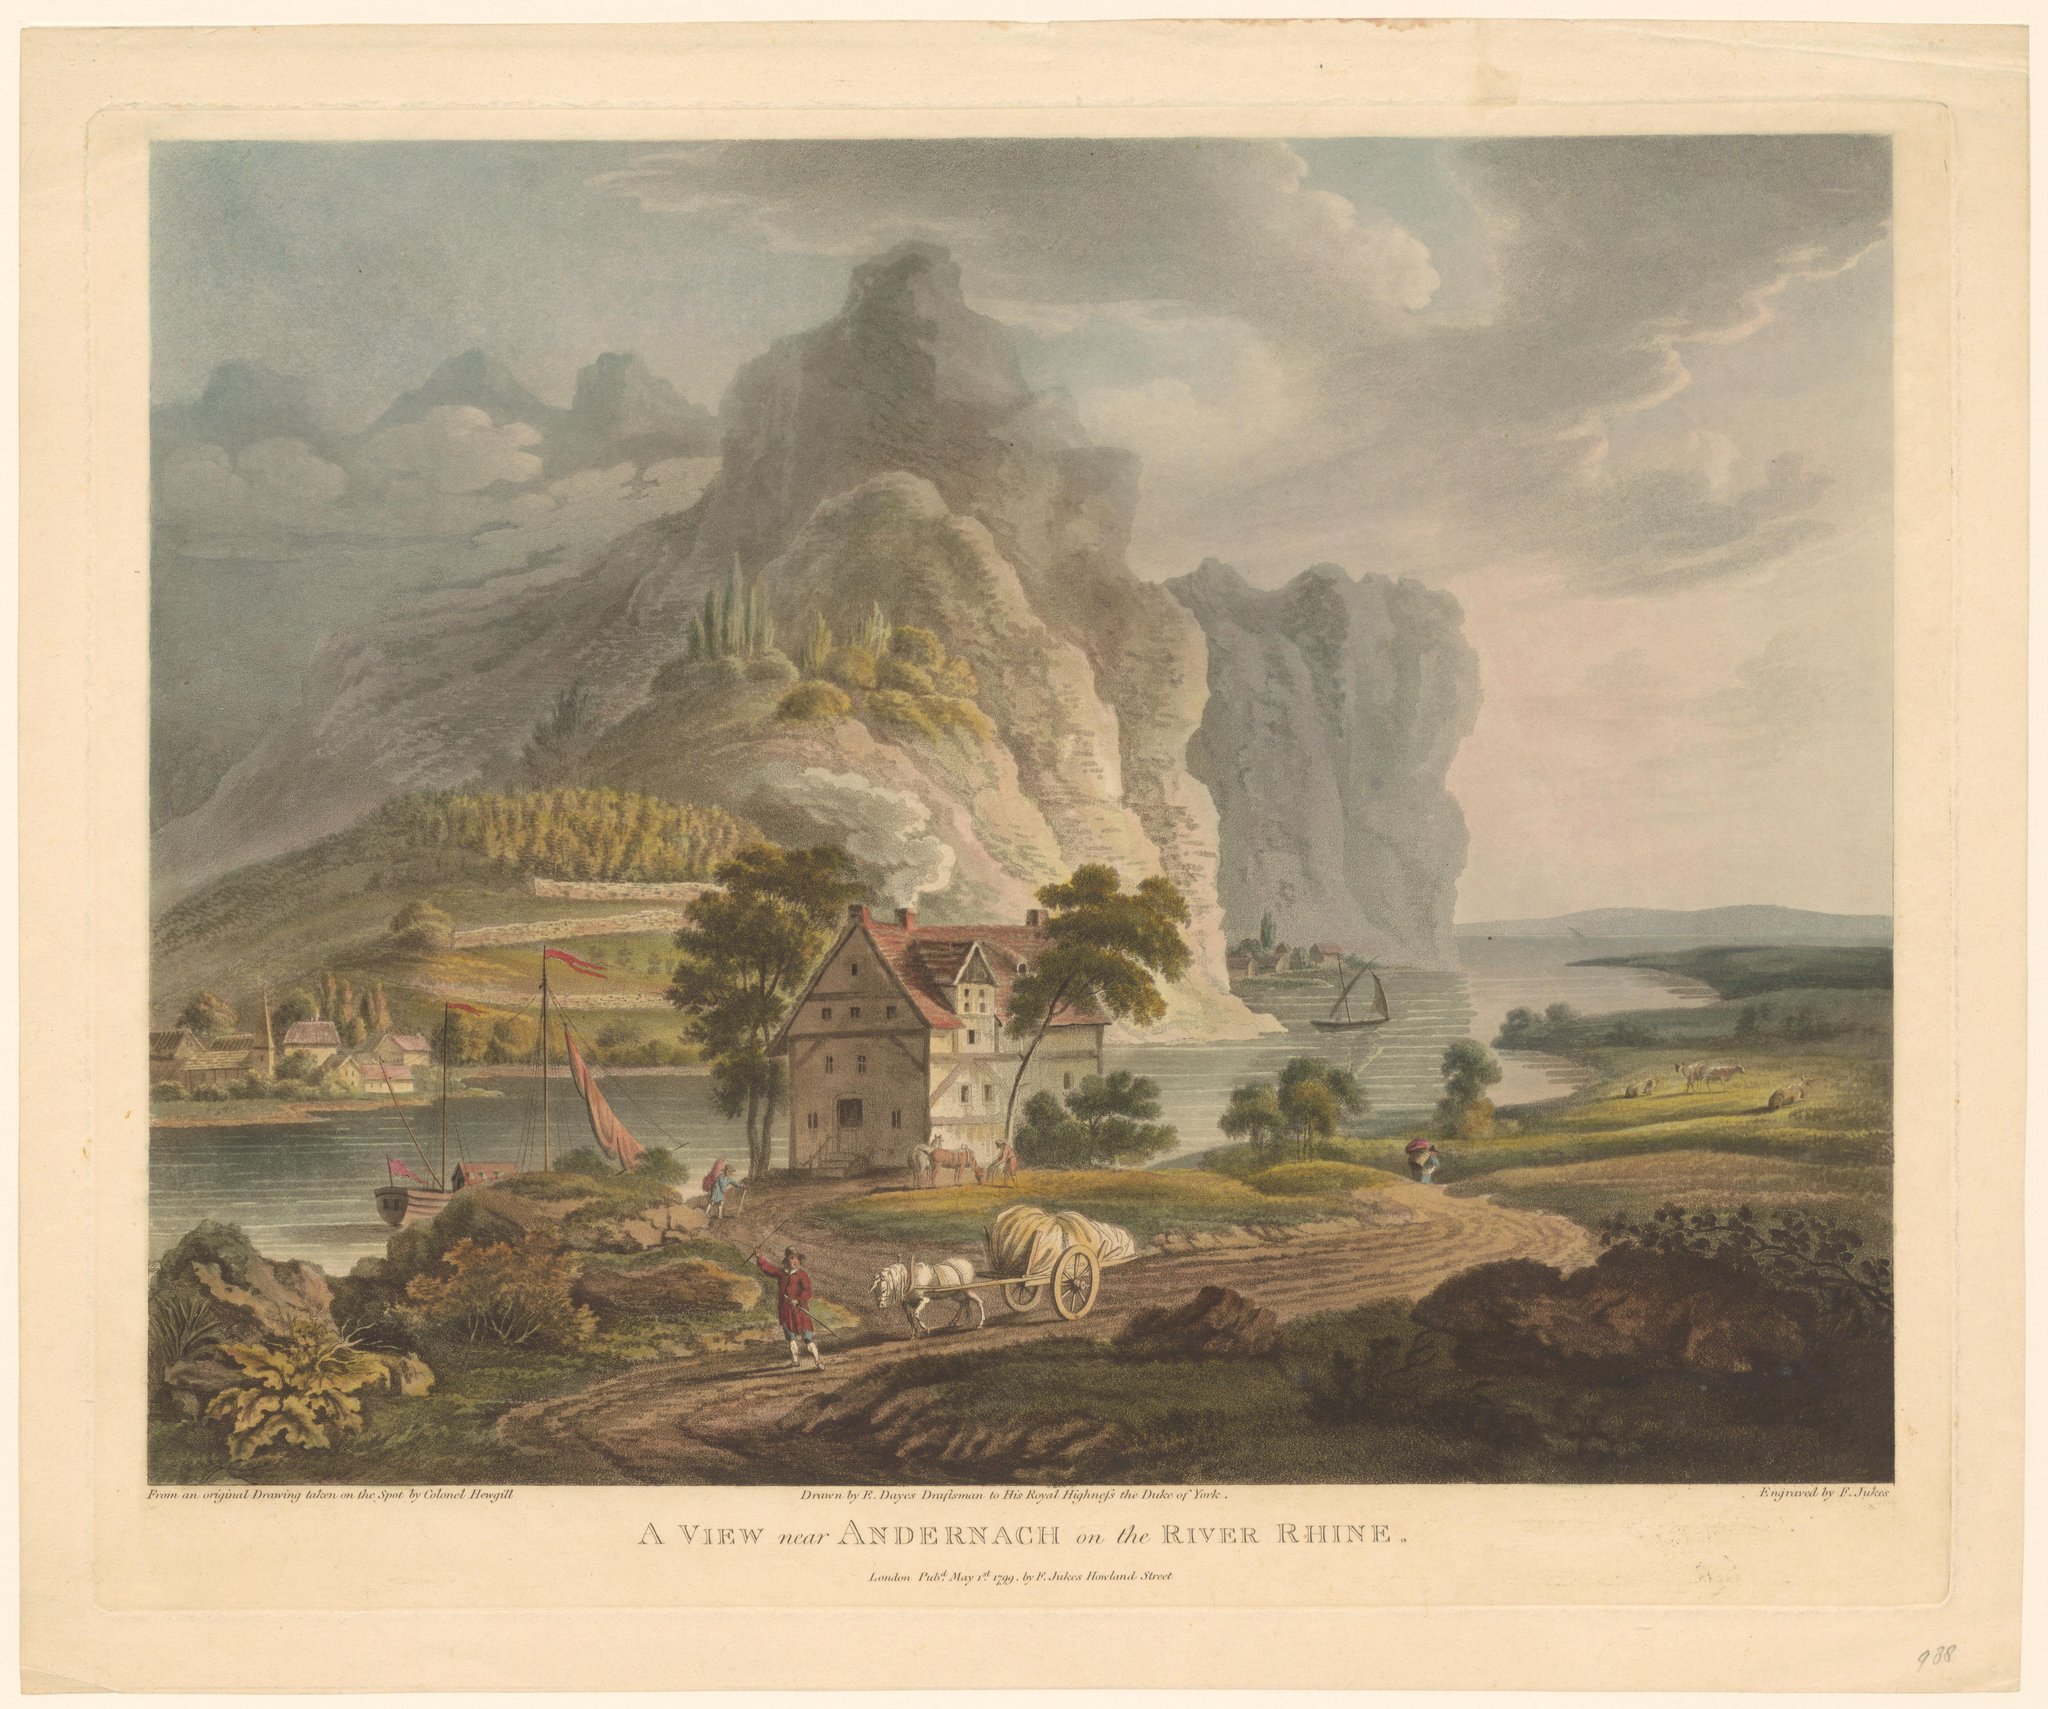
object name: print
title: A View near Andernach on the River Rhine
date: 1799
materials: paper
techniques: aquatint, hand coloring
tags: river (+ landscape with figures, staffage), (high) hill (+ landscape with figures, staffage)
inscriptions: collector's mark: Lugt 2228